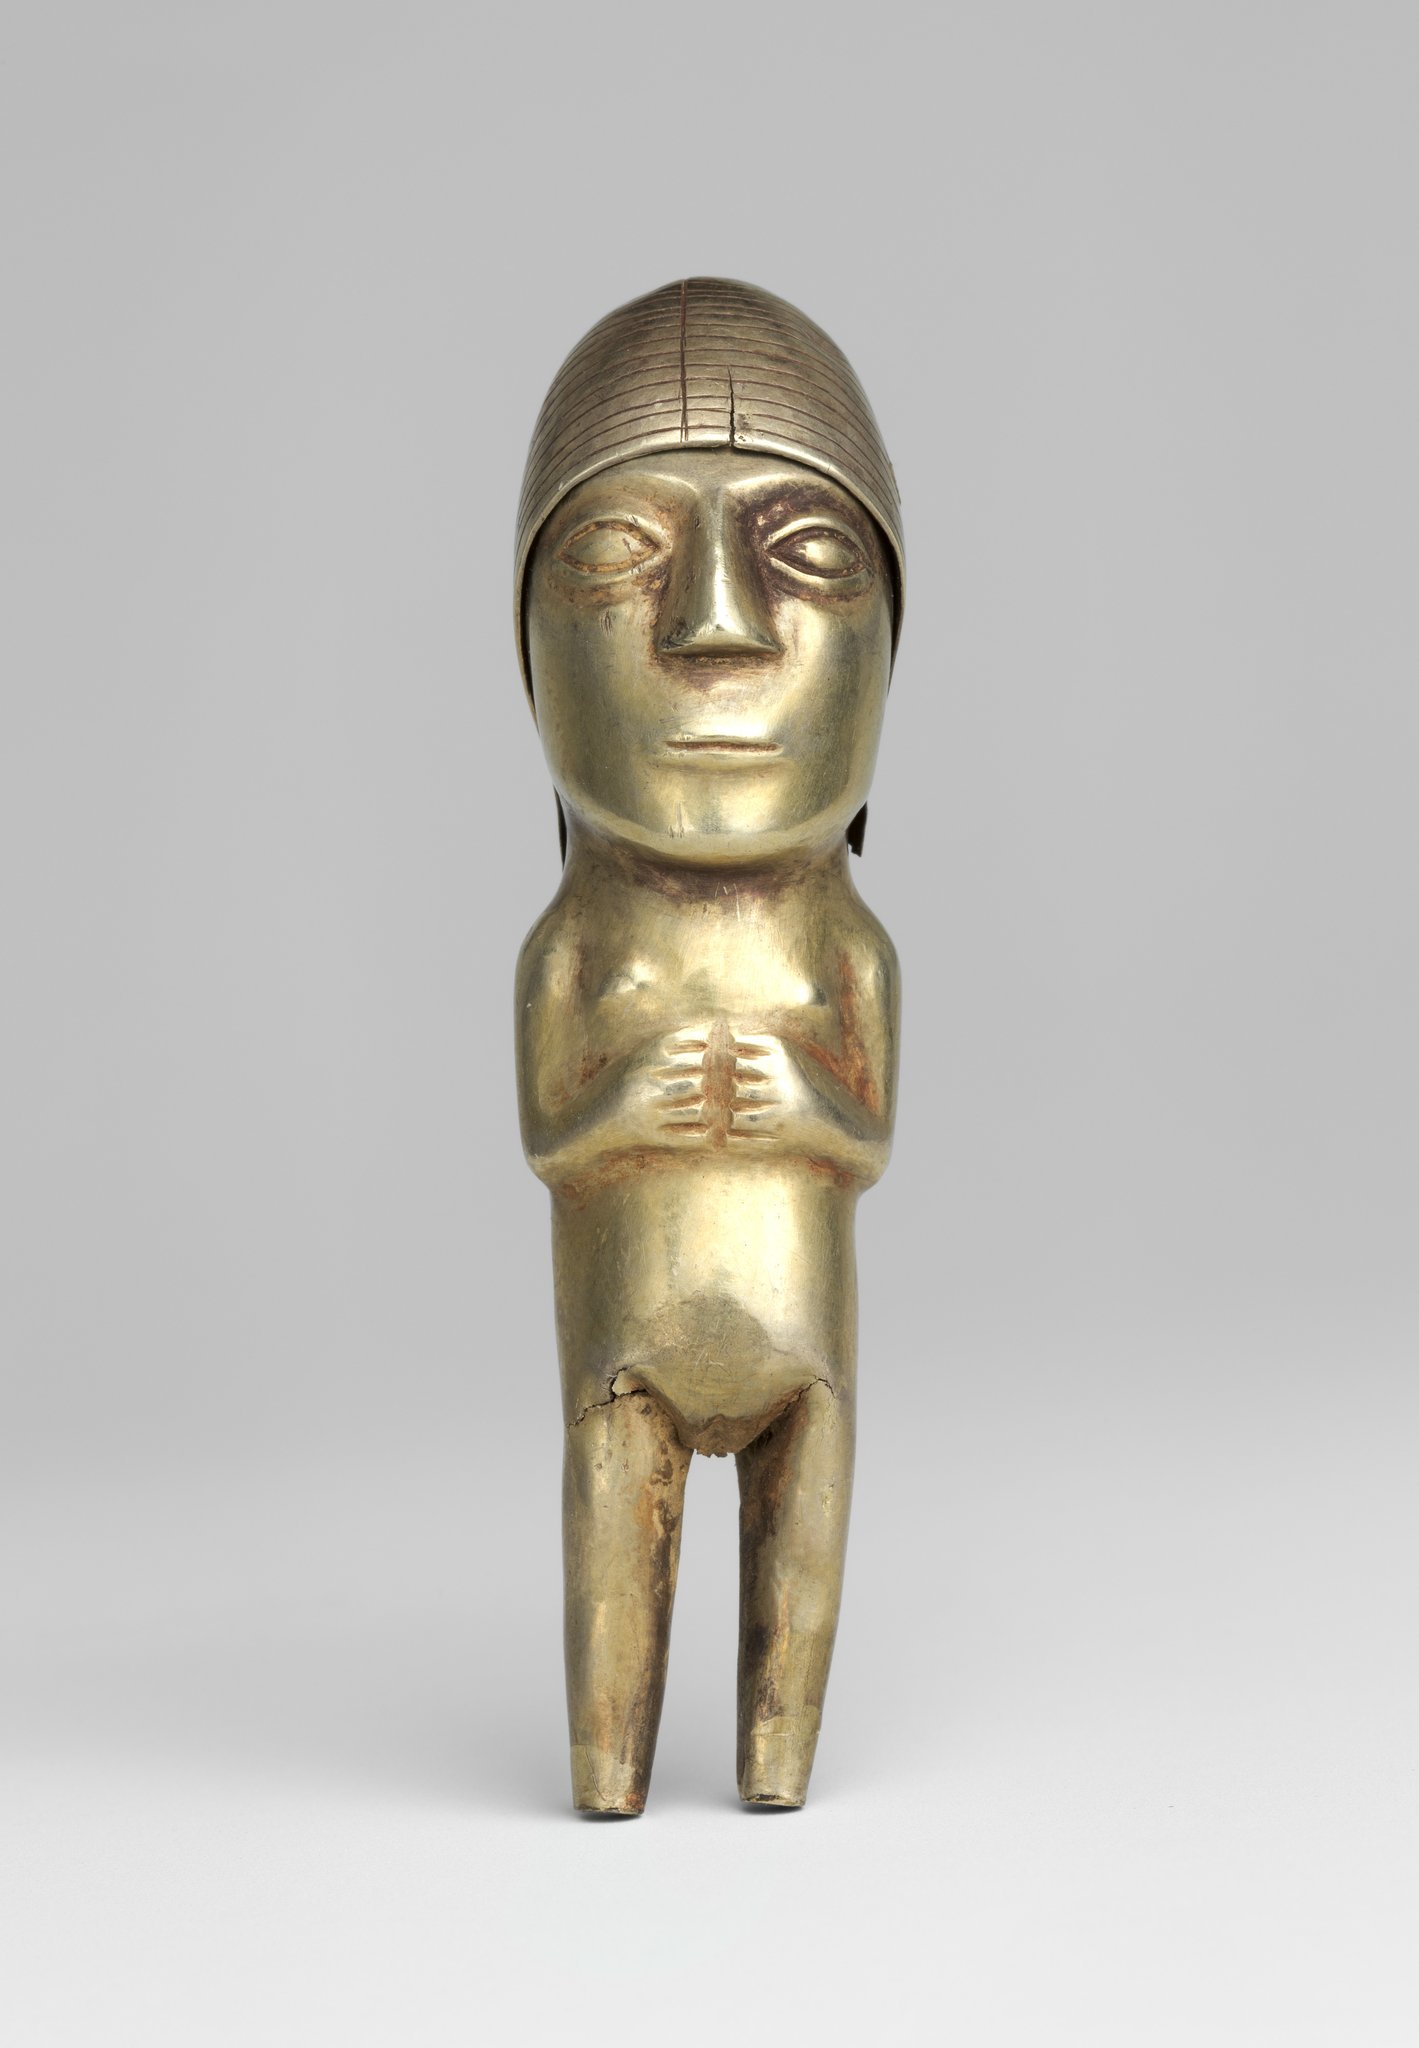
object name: figure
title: Miniature female effigy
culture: inca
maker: inca artist(s)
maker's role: artist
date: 1400-1535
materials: alloy, gold, silver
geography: ecuador, peru, bolivia, chile, or argentina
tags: women